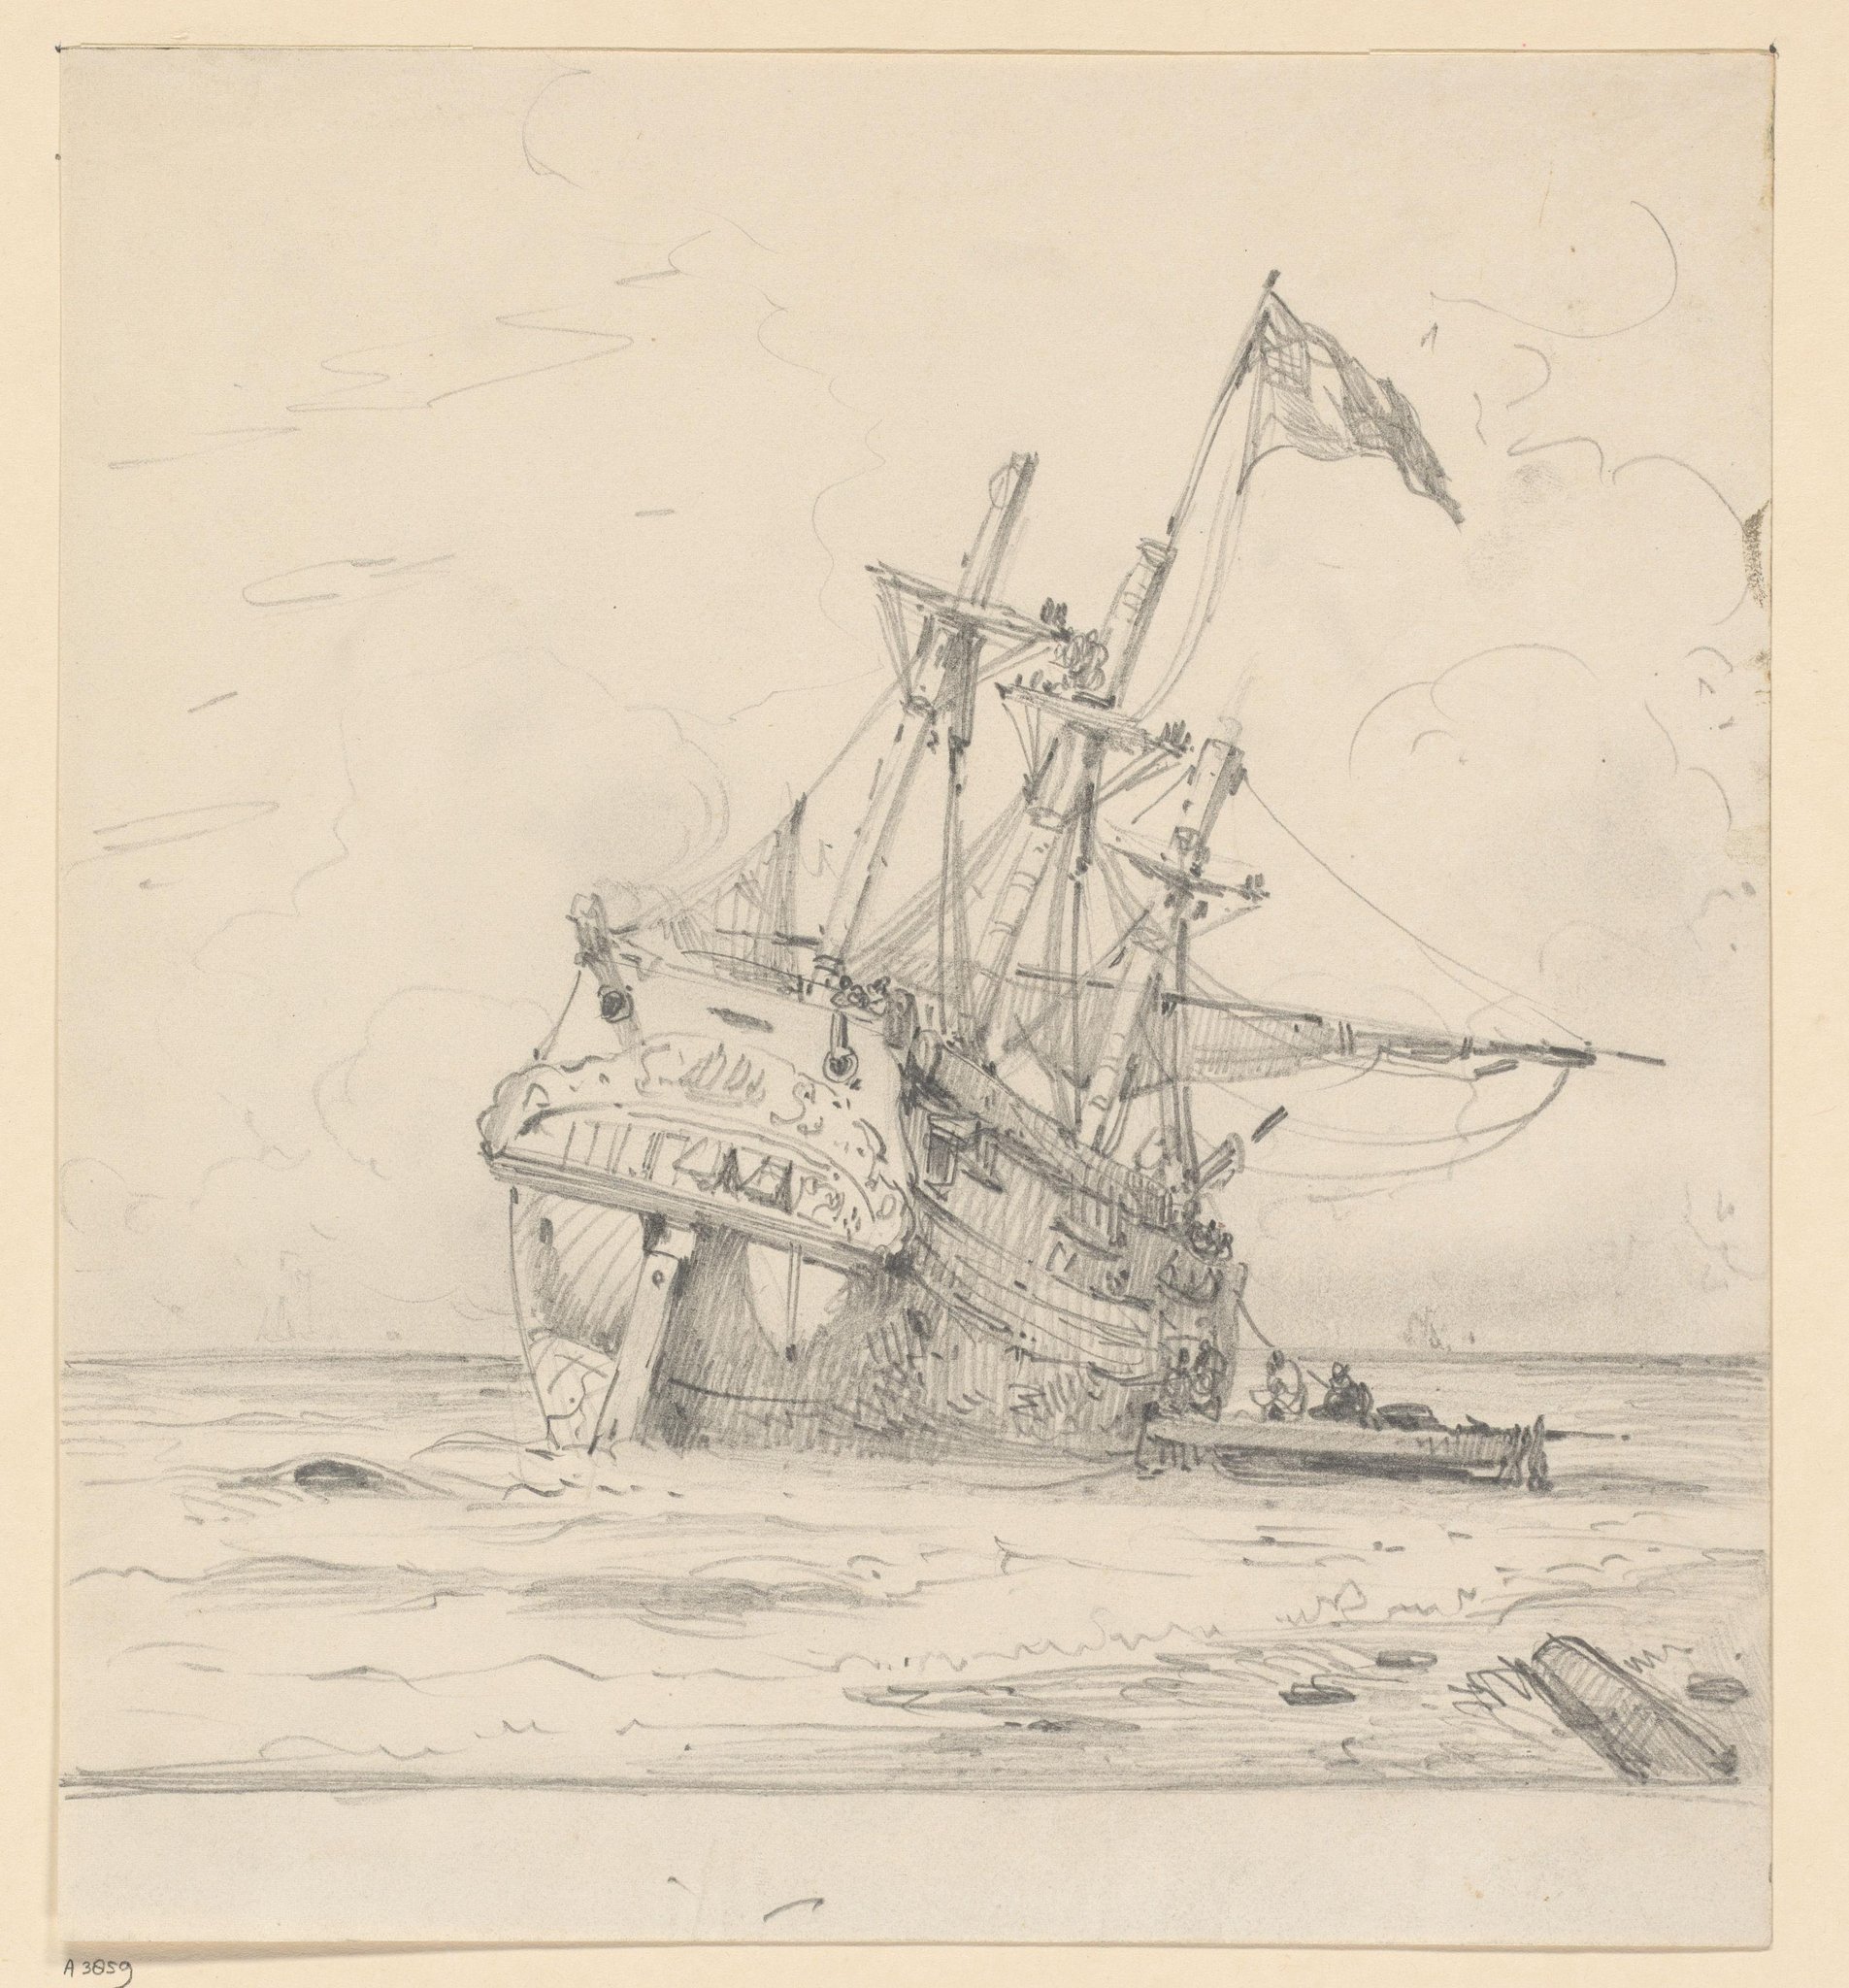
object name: drawing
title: Gestrande en deels gesloopte driemaster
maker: willem anthonie van deventer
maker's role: draughtsman, painter, print maker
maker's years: 1824-1893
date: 1834-1893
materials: paper, pencil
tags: sailing-ship, sailing-boat